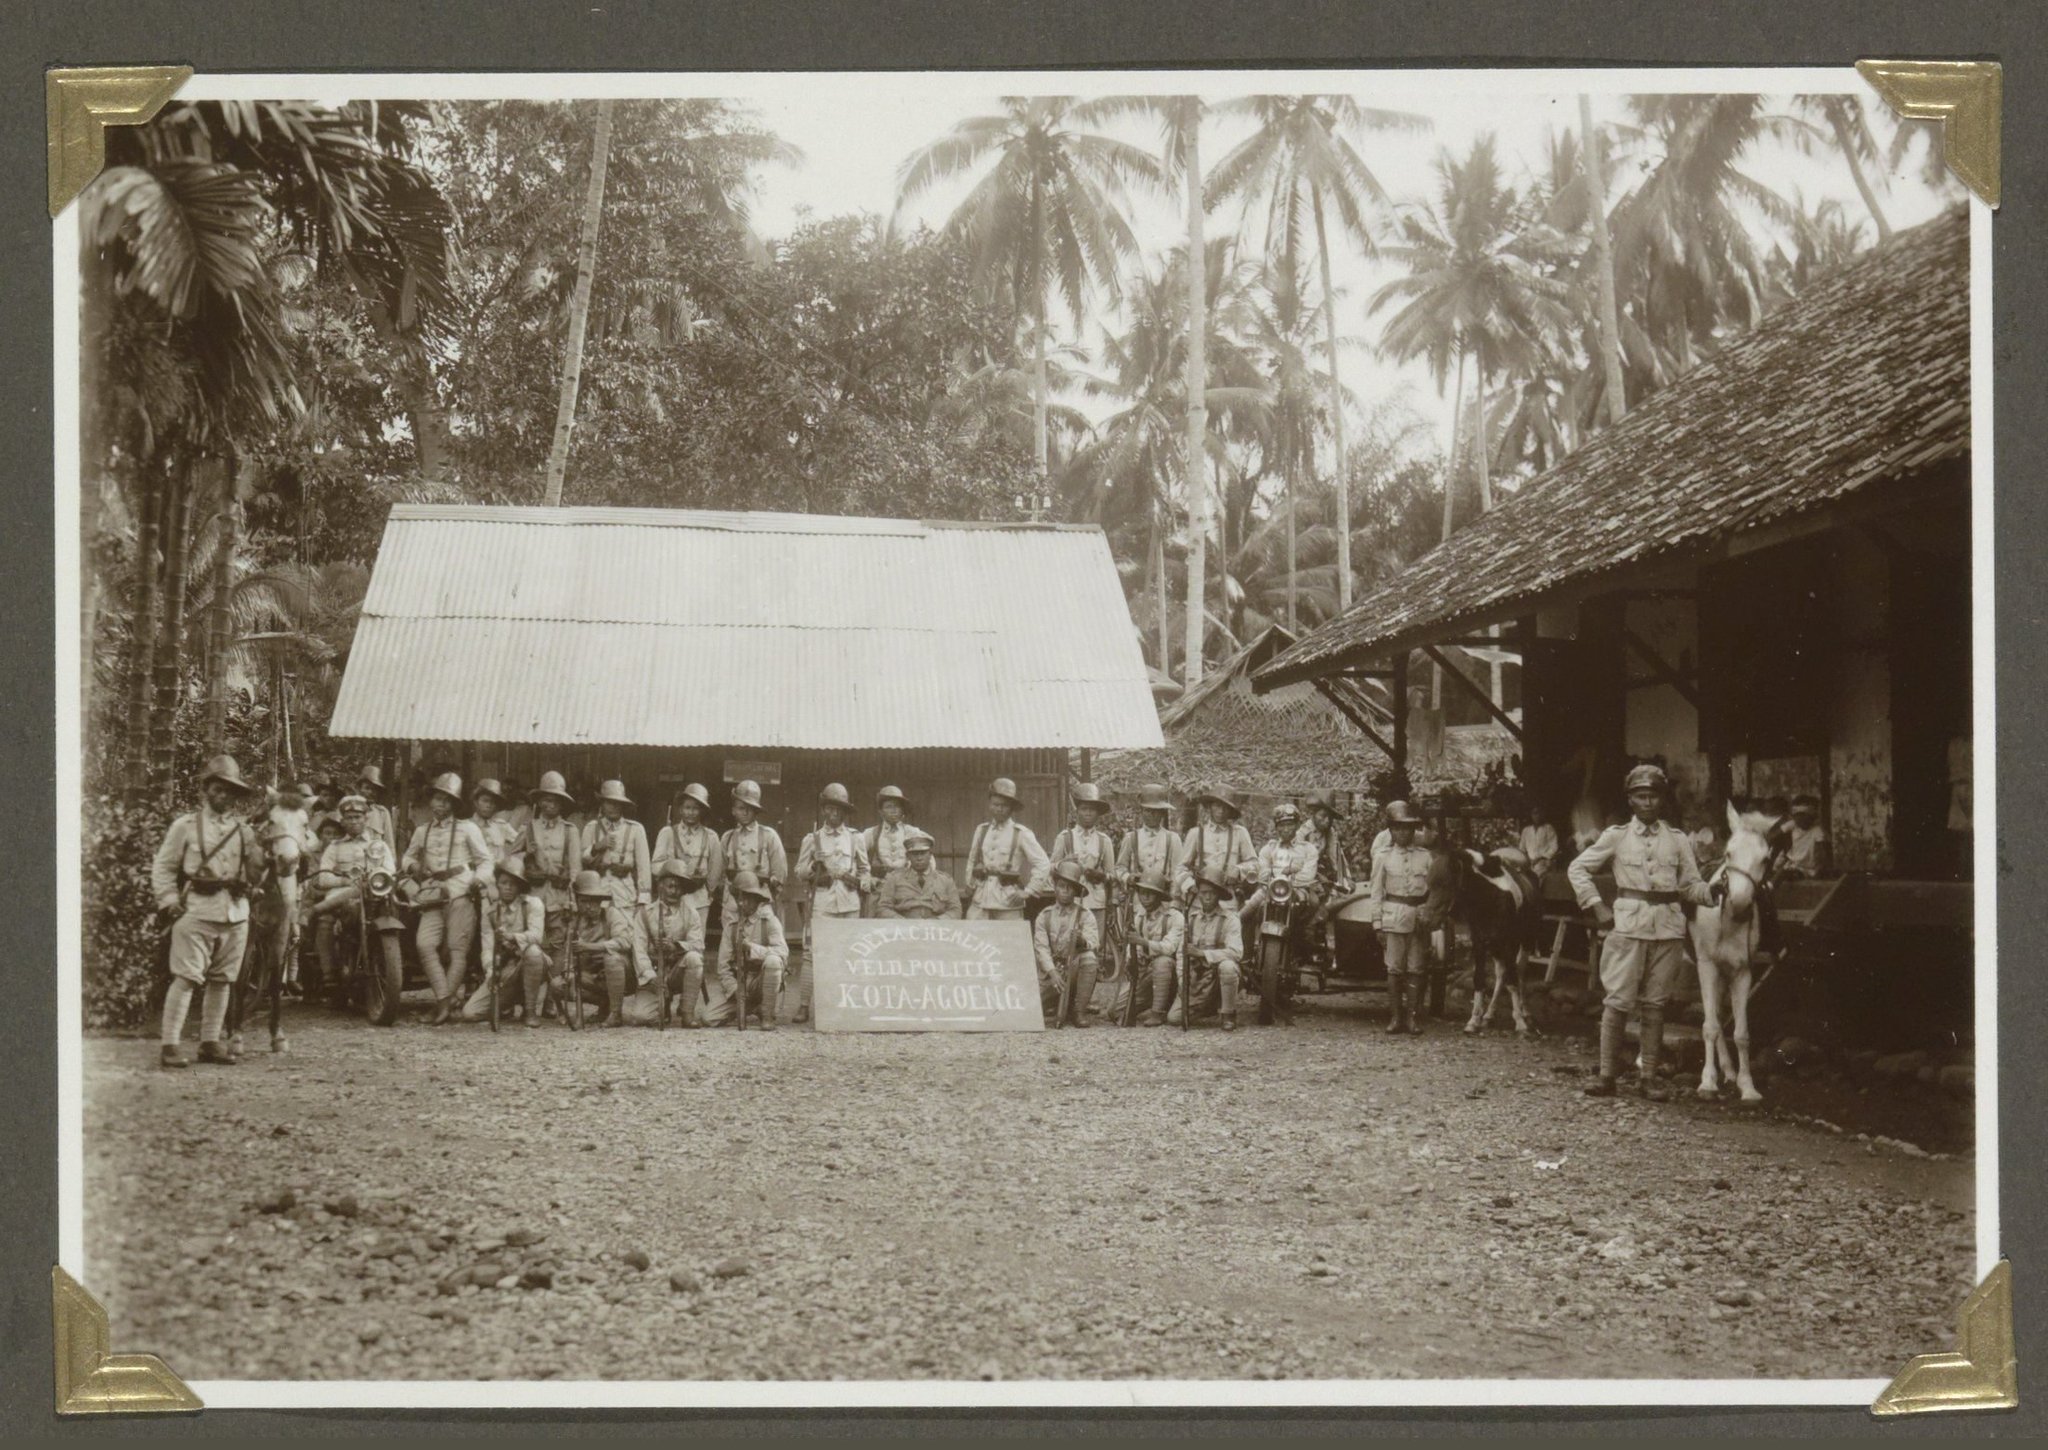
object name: photograph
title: Groepsportret van leden van de veldpolitie bij hun kazerne in Kotaagung (Zuid-Sumatra)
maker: Anonymous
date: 1932-1933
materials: photographic support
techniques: gelatin silver print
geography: lampung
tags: barracks, police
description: Onderdeel van Herinneringsalbum voor F.J. Junius, vertrekkend resident van Lampong (Zuid-Sumatra).